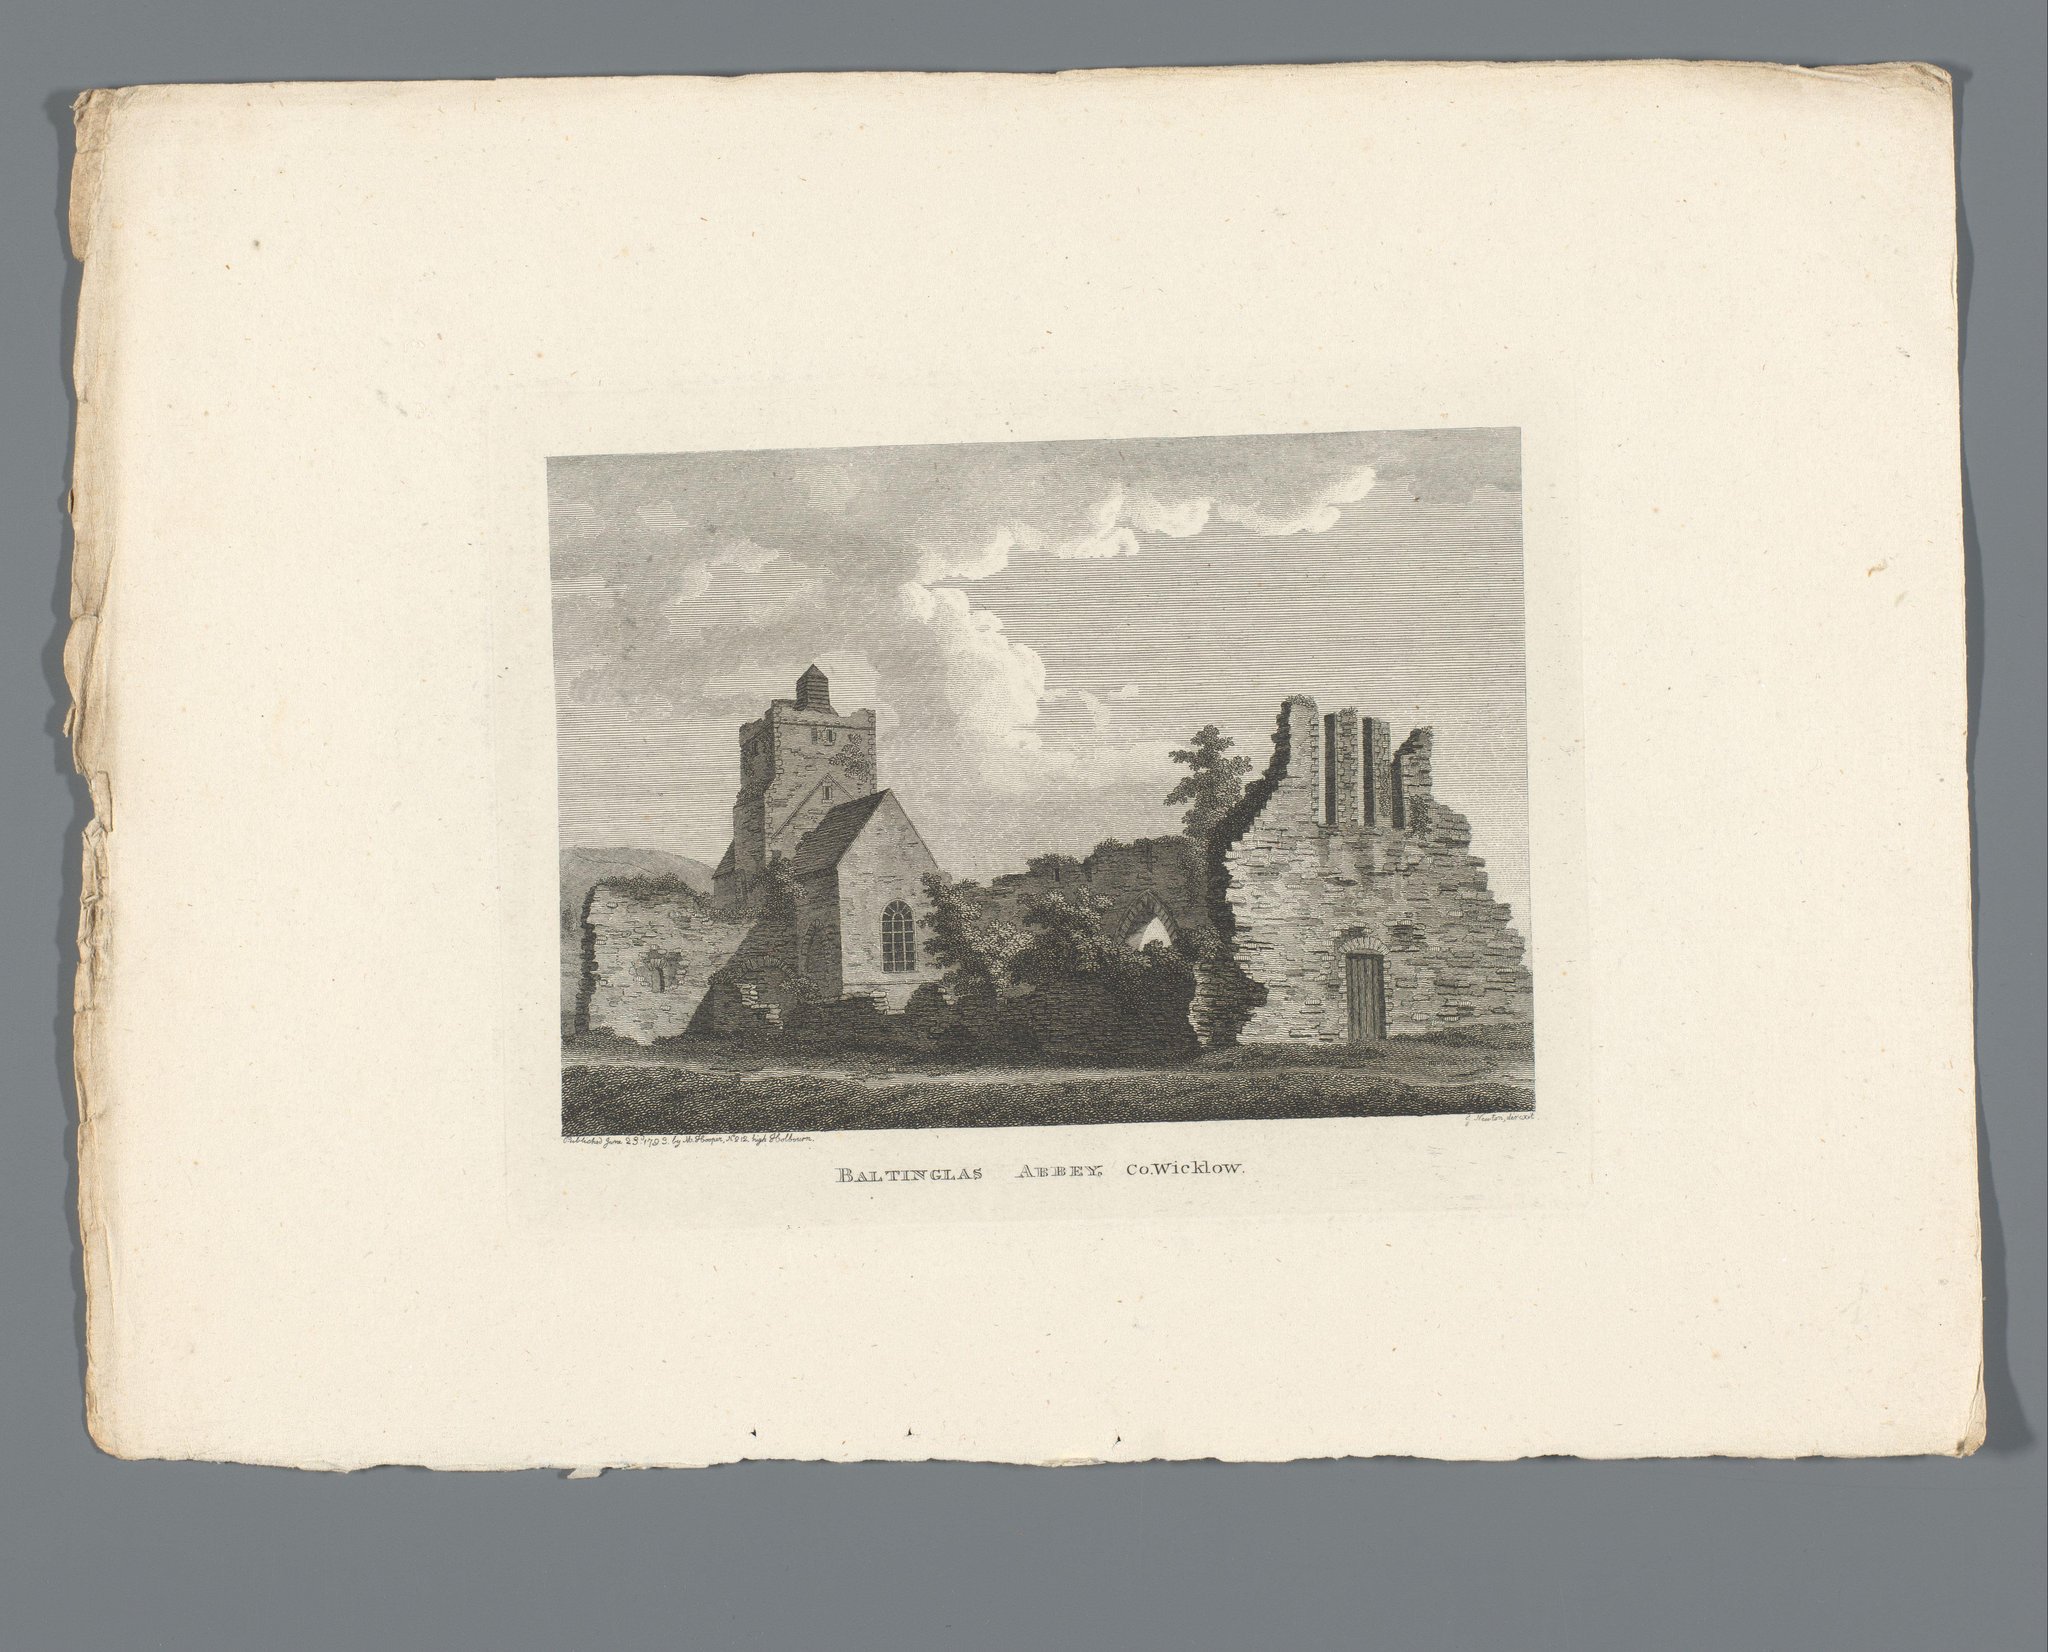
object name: book illustration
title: Gezicht op de ruïnes van de abdij in Baltinglass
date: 1793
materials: paper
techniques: etching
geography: london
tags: city-view, and landscape with man-made constructions, abbey, monastery, convent ~ roman catholic church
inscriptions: date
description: Prent verschenen in: Grose, Francis. The antiquities of Ireland, dl. 2. Londen: S. Hooper, 1795.